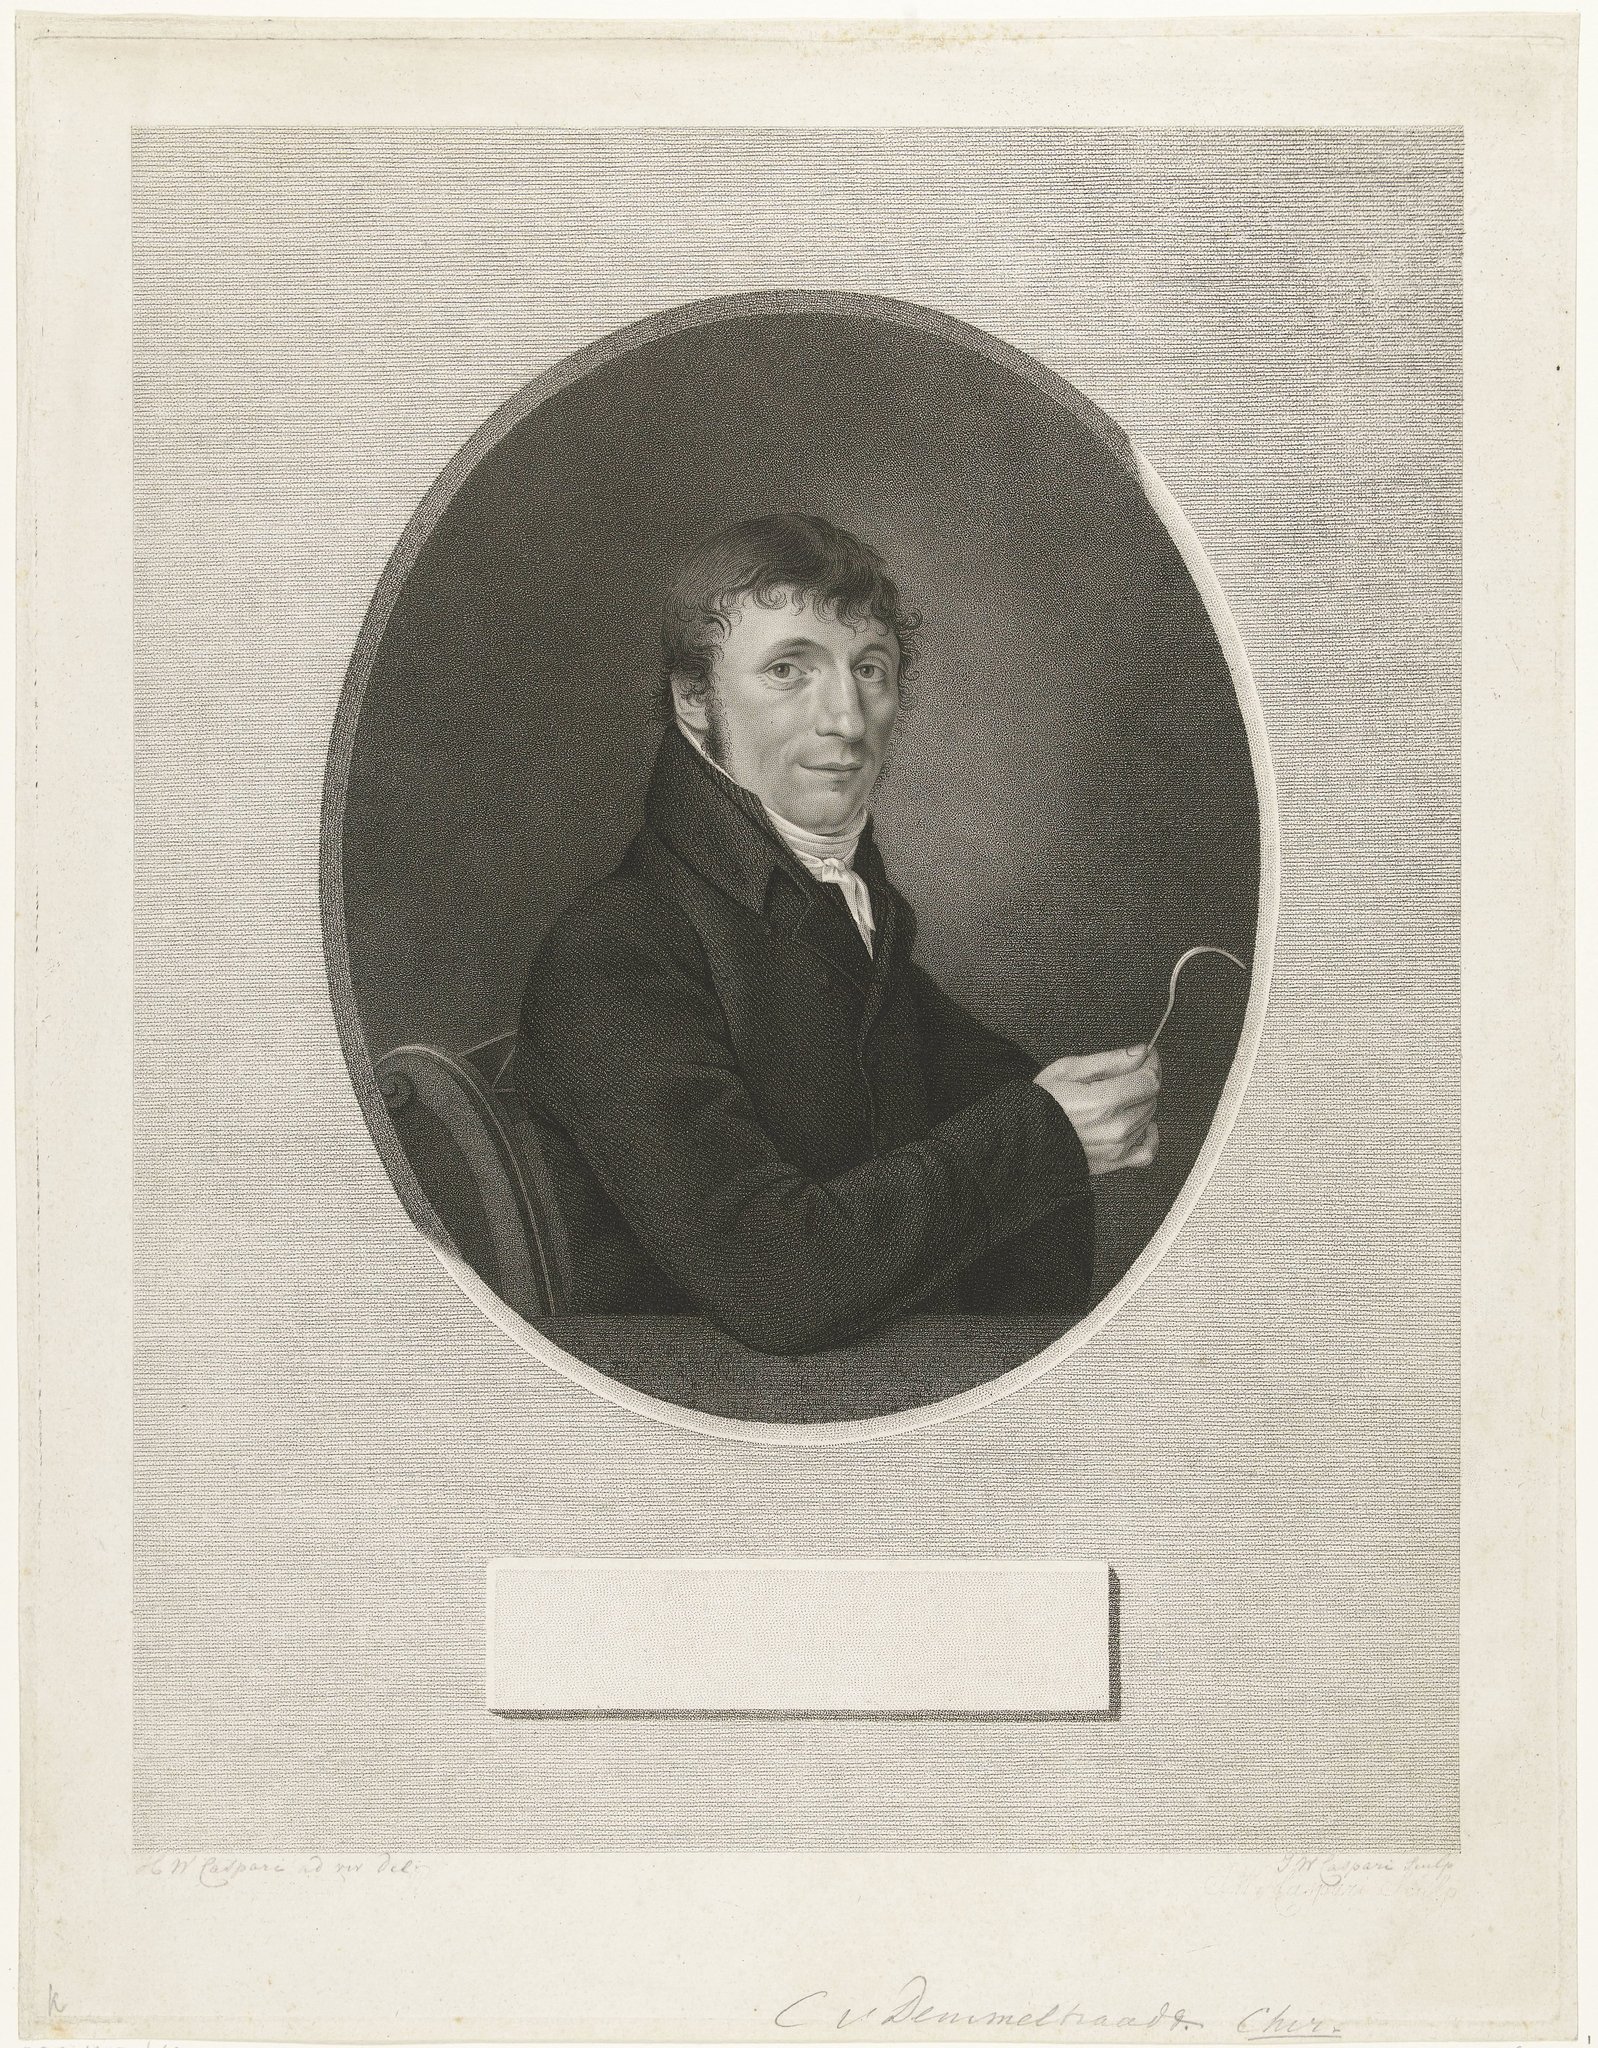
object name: print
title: Portret van Clemens van Demmeltraadt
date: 1789-1822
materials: paper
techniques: etching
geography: amsterdam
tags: clemens van demmeltraadt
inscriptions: collector's mark: Lugt 2228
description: Portret in ovale lijst van Clemens van Demmeltraadt, chirurgijn van Amsterdam. Van Demmeltraadt zit op een stoel, buste licht naar rechts. In zijn handen een chirurgisch instrument.